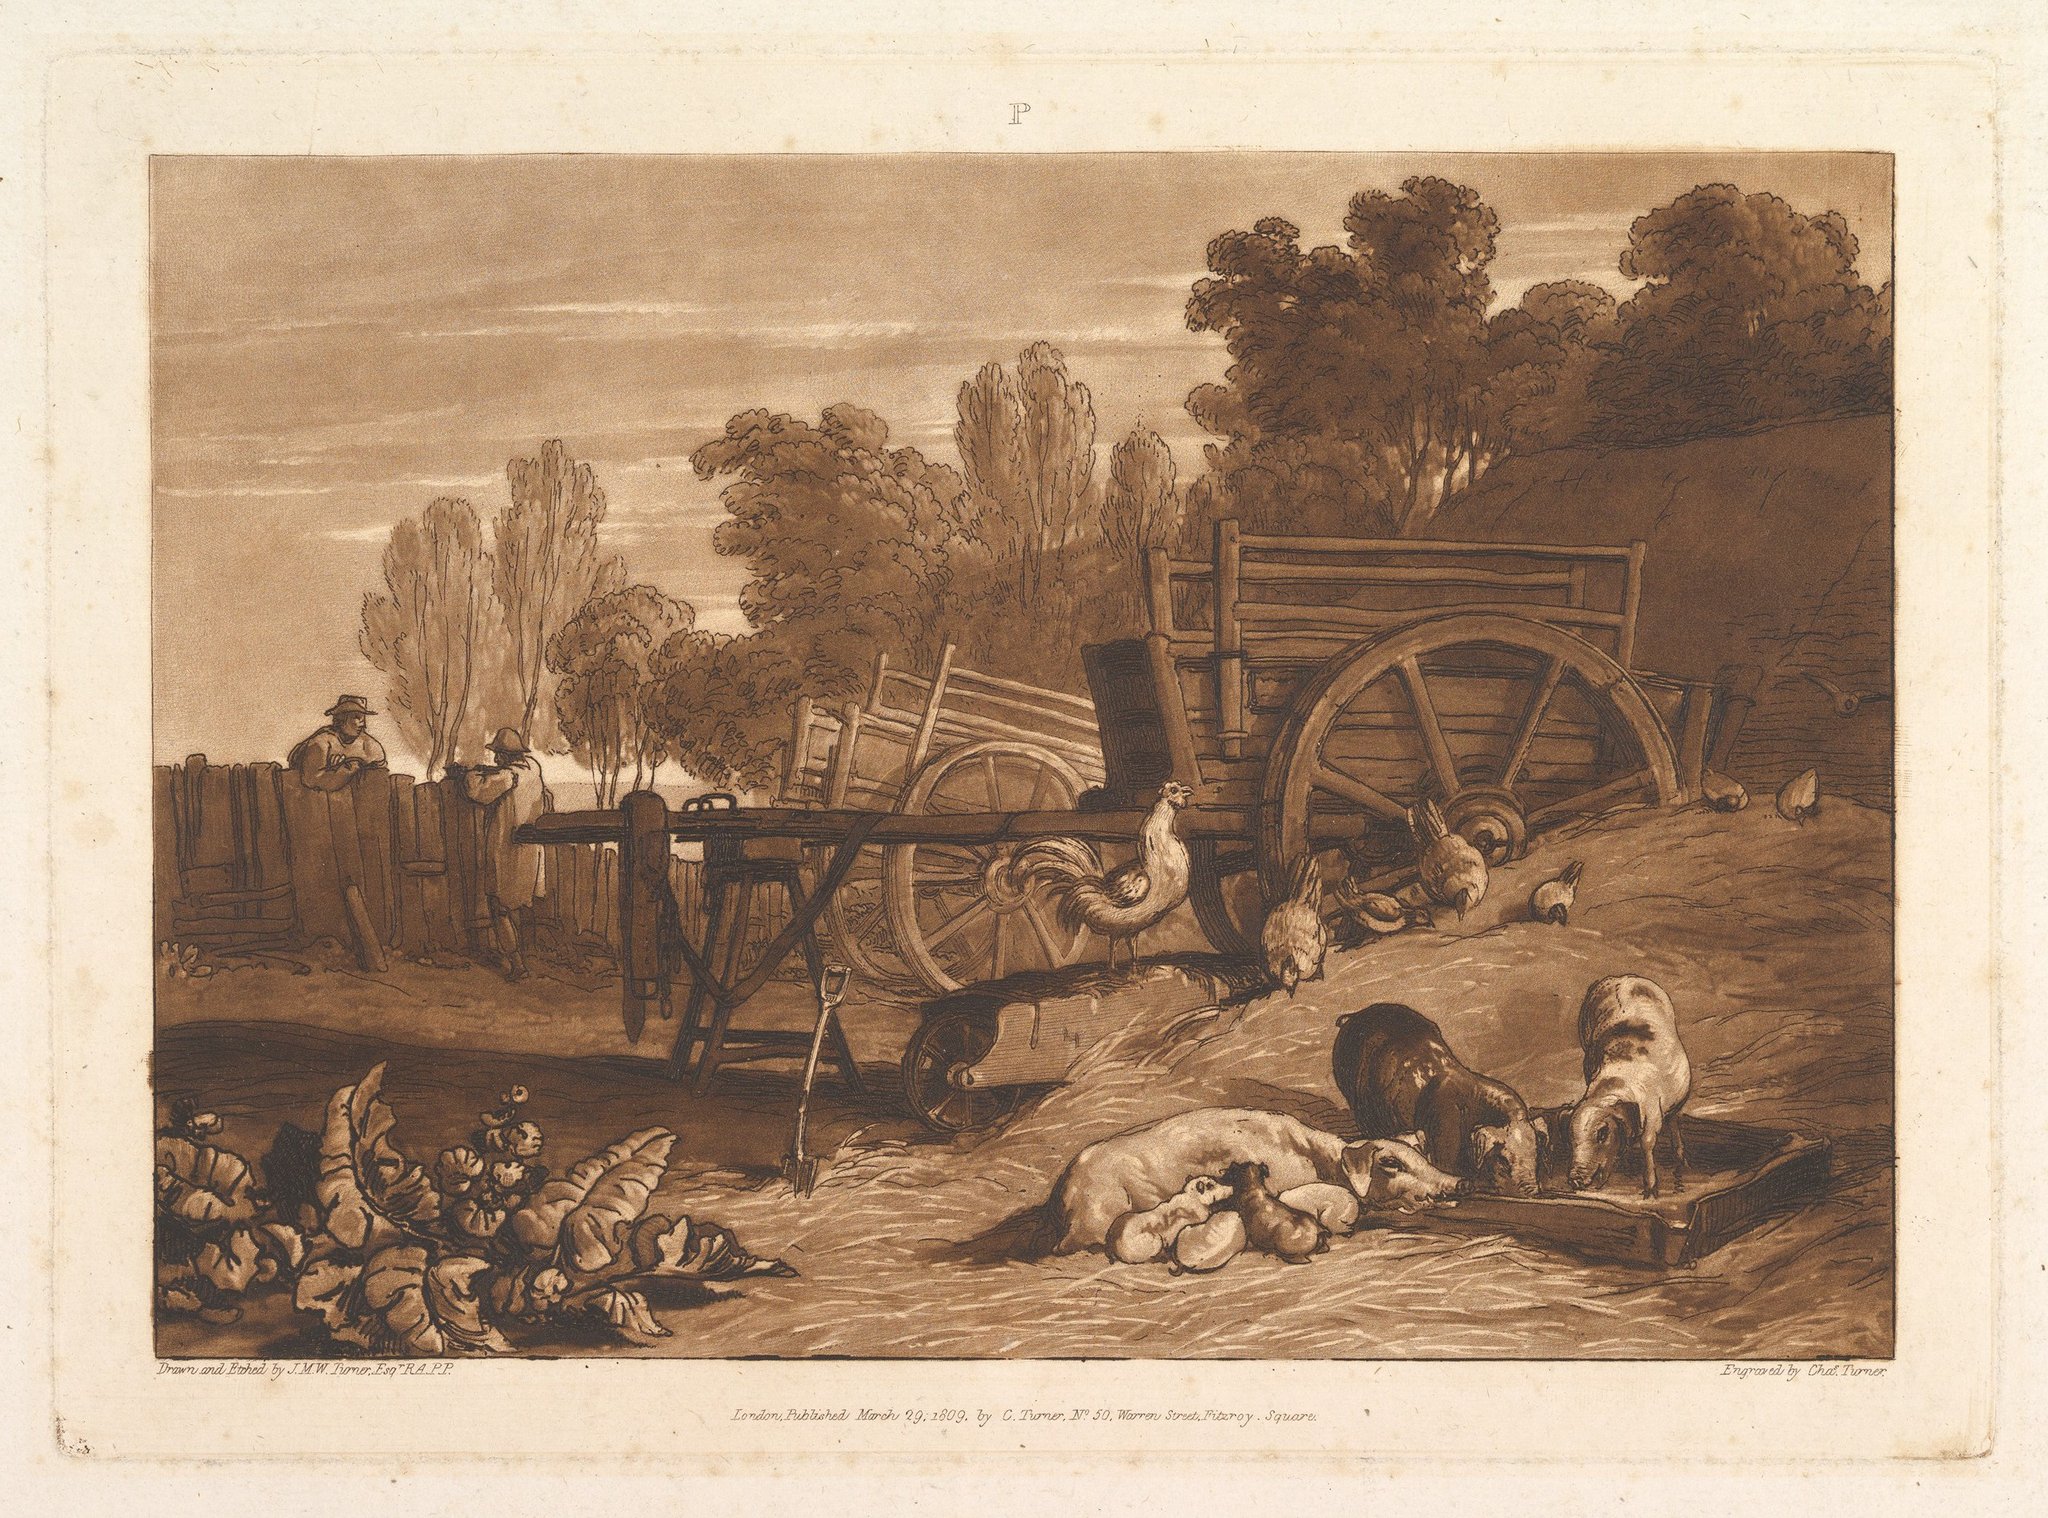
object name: print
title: The Farm-Yard with the Cock, part IV, plate 17 from "Liber Studiorum"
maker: joseph mallord william turner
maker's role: artist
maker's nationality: british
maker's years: 1775-1851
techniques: etching, mezzotint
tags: farms,men,roosters,pigs,pastoral